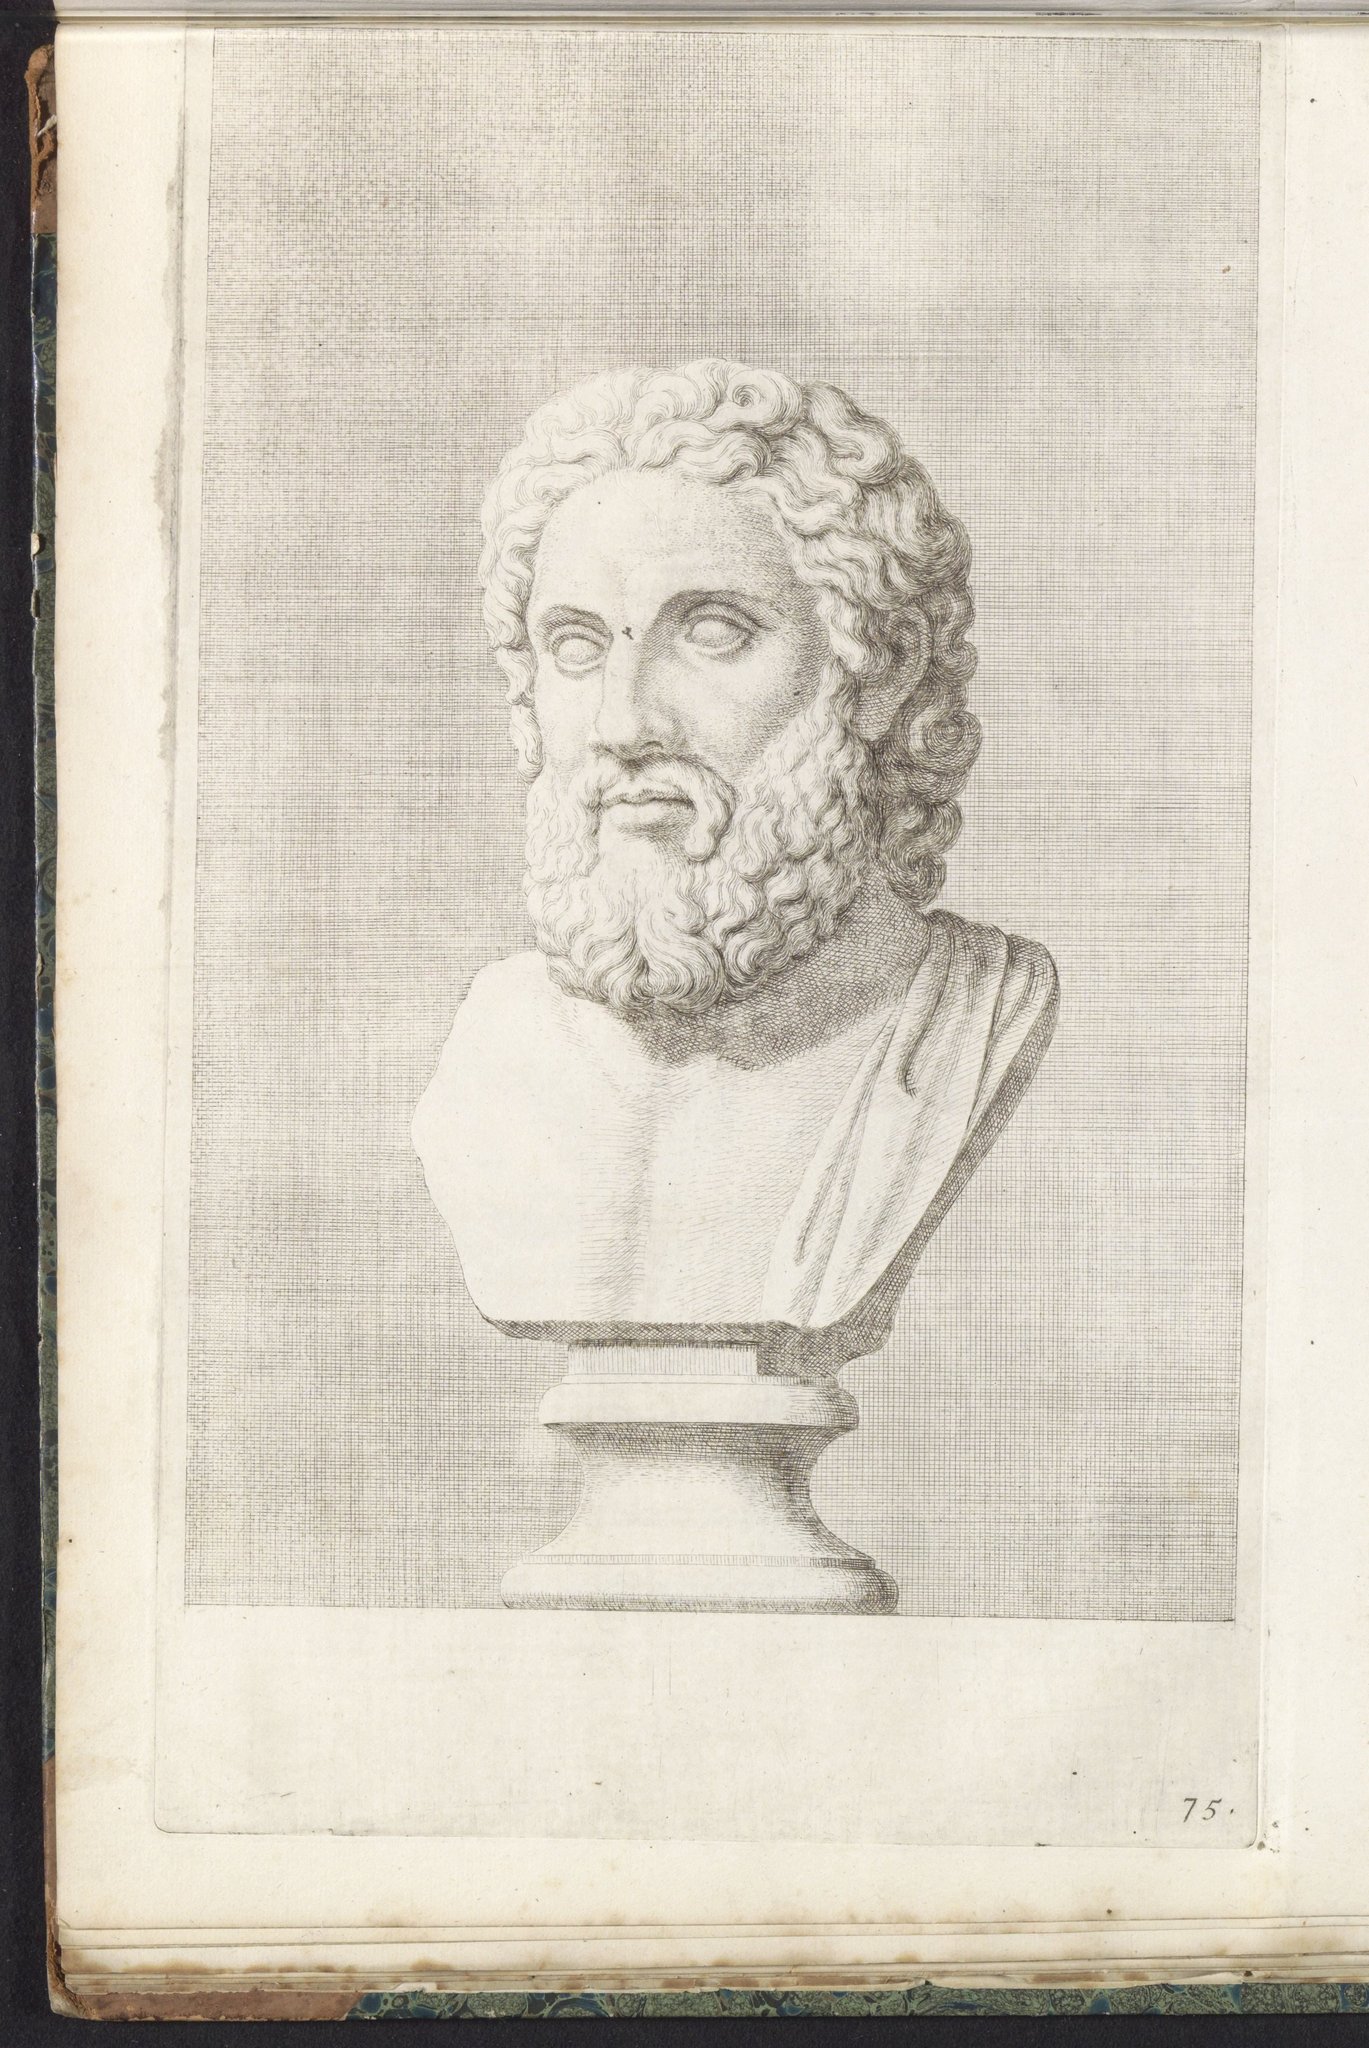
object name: album leaf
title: Buste van een bebaarde man, naar links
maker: hubert quellinus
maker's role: print maker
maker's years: 1619-1687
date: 1646-1670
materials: paper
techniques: engraving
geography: antwerp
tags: piece of sculpture, reproduction of a piece of sculpture, male persons from classical history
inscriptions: number: ‘77’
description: De prent maakt deel uit van een album met een serie prenten naar de sculpturen in de verzameling van Gerard Reynst.